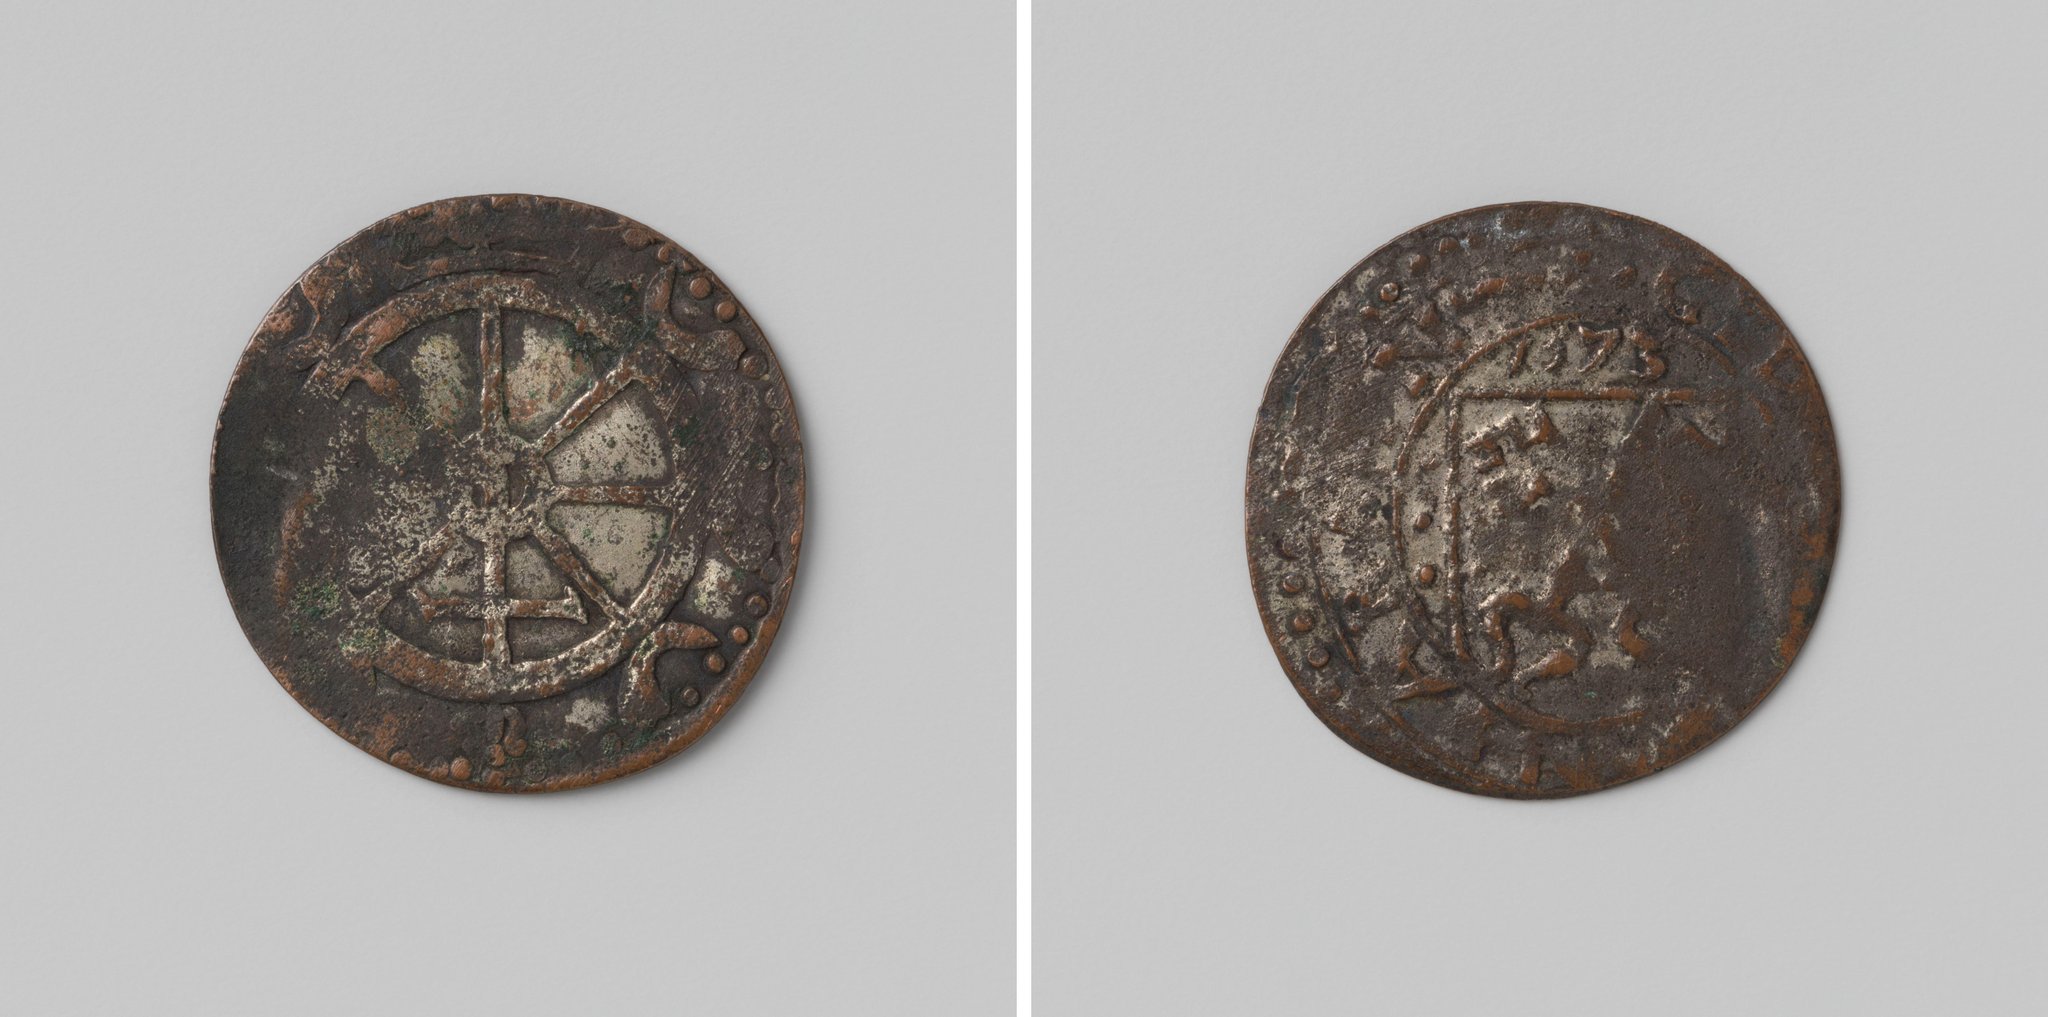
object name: alms token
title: Oord, kwart stuiver van het Catharina-gasthuis van Leiden, circuleerde in de periode 1573-1576 als kleingeld in Leiden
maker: Anonymous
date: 1573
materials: silver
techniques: striking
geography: leiden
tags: leiden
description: Zilveren penning. Voorzijde: gekroond rad. Keerzijde: wapenschild onder jaartal binnen omschrift.